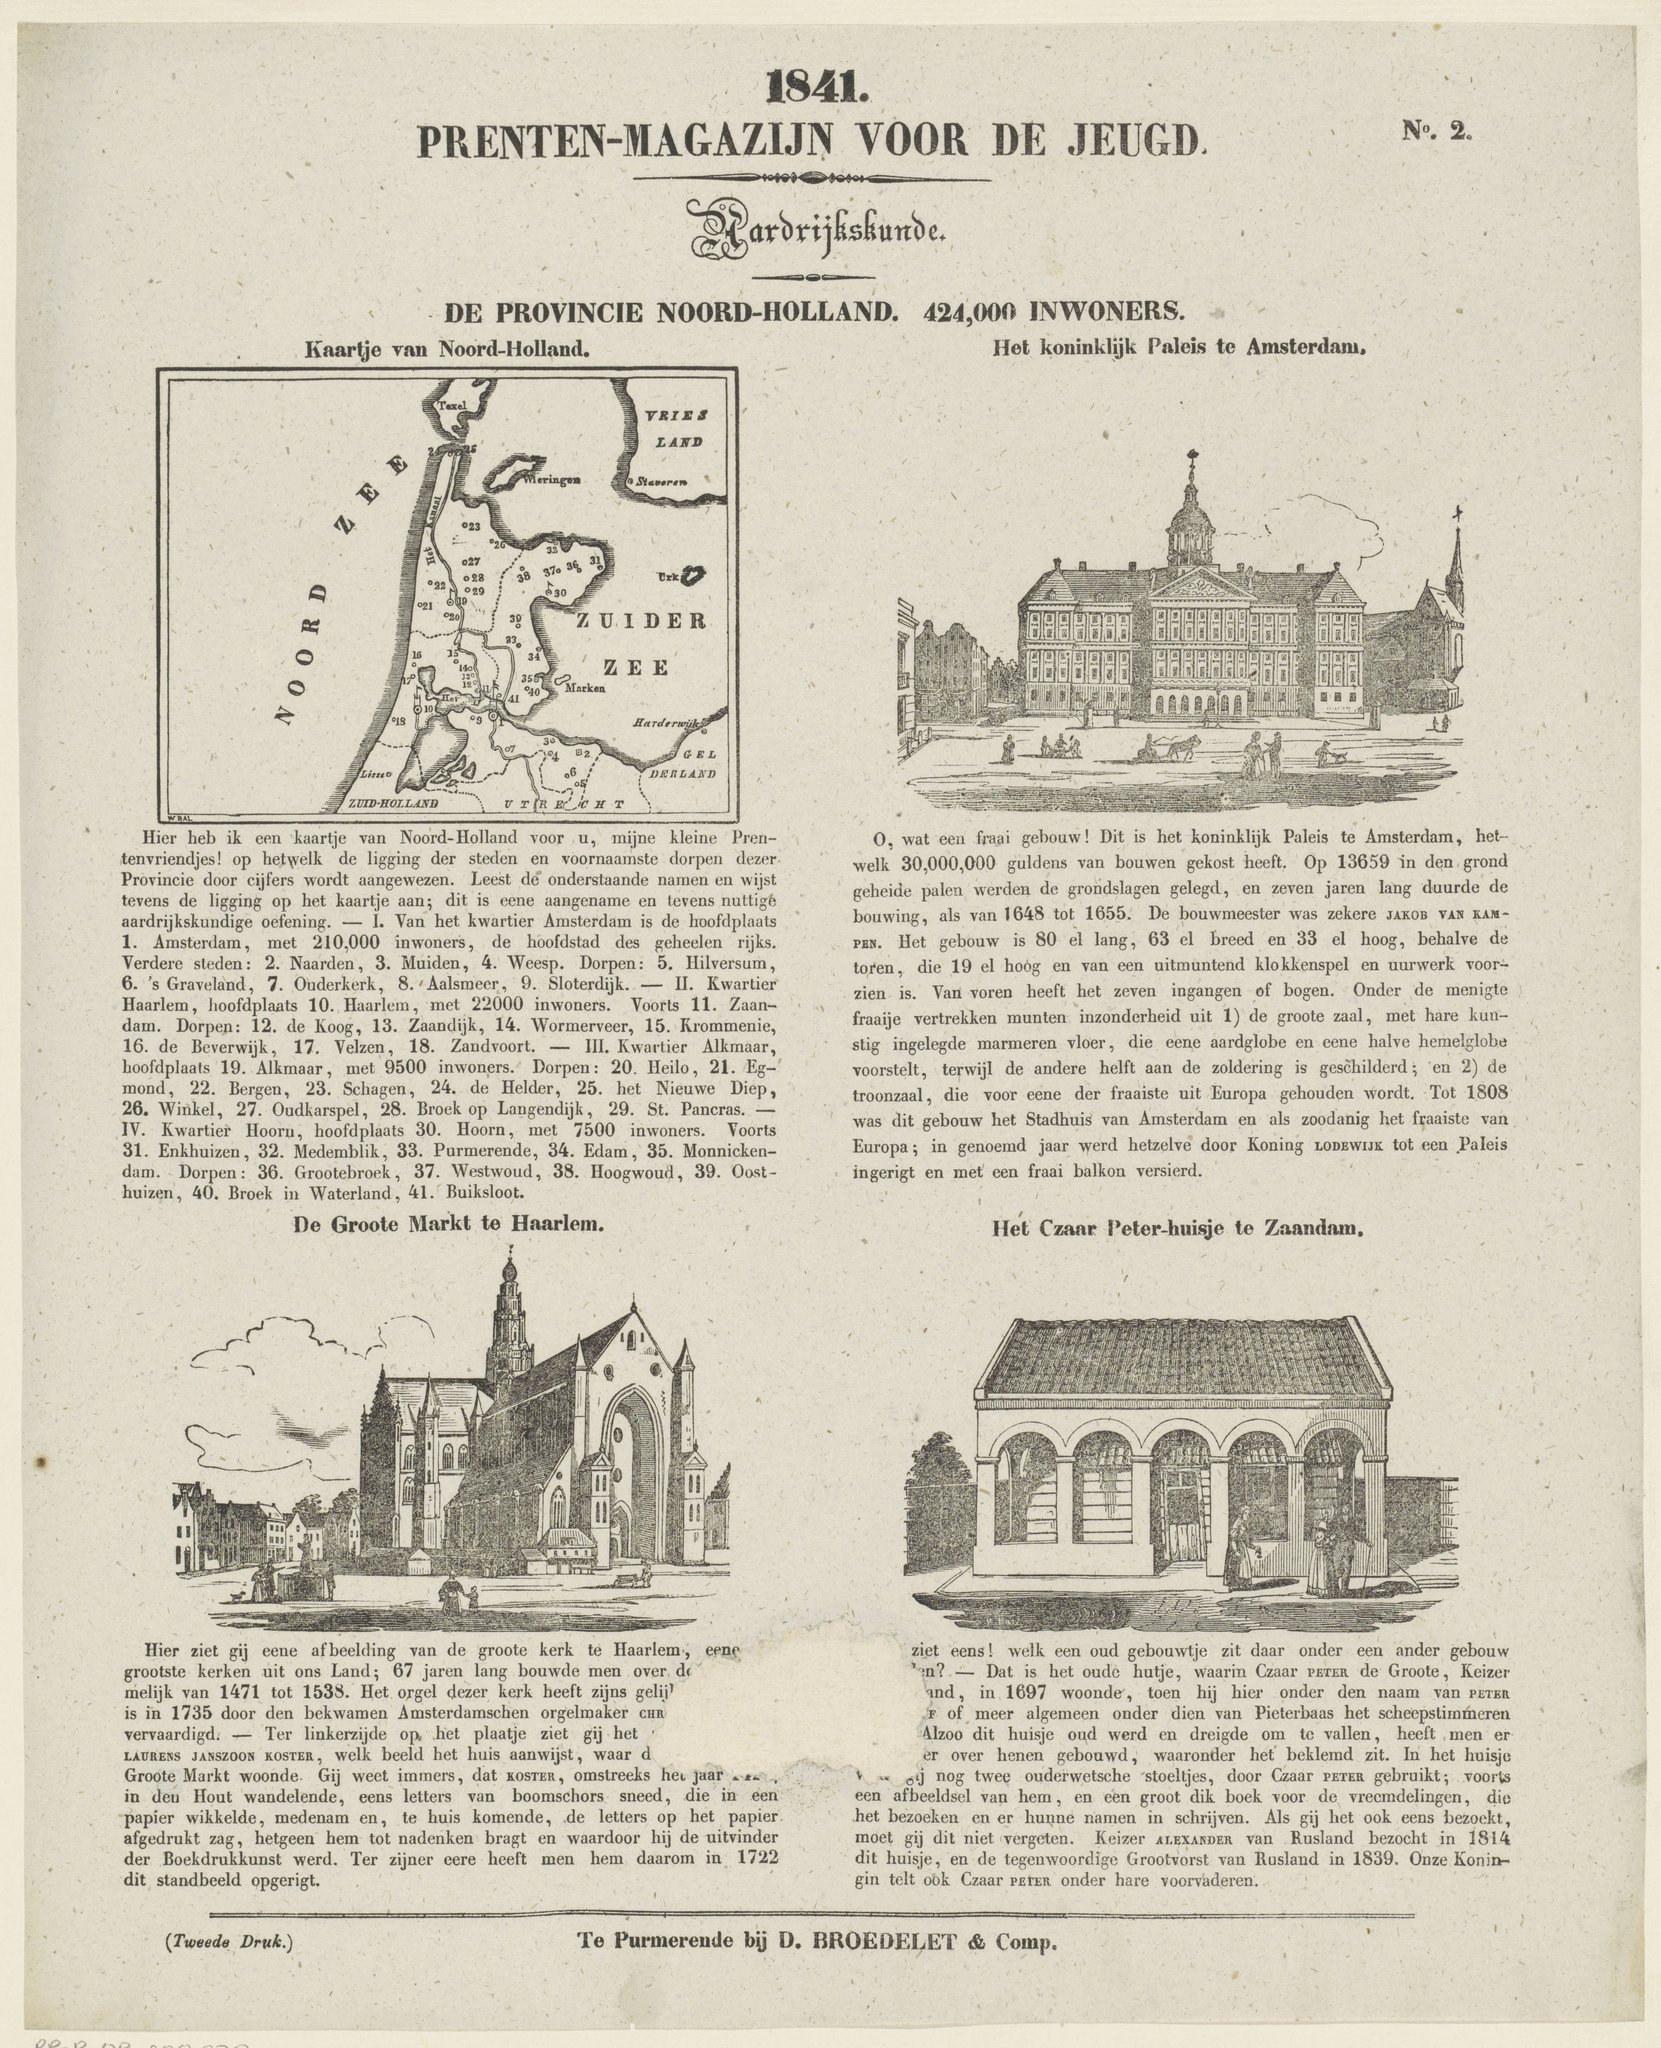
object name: popular print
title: Aardrijkskunde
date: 1841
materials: paper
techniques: letterpress printing, engraving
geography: purmerend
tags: maps, atlases, palace, roman catholic church, royal palace of amsterdam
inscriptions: collector's mark: Lugt 2760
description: Blad met 4 voorstellingen over de provincie Noord-Holland met een kaart en belangrijke gebouwen: het Paleis op de Dam te Amsterdam, de Grote Markt in Haarlem en het Czaar Peterhuisje te Zaandam. Boven elke voorstelling een titel en onder elke voorstelling twaalf tot achttien regels tekst. Genummerd rechtsboven: No. 2.